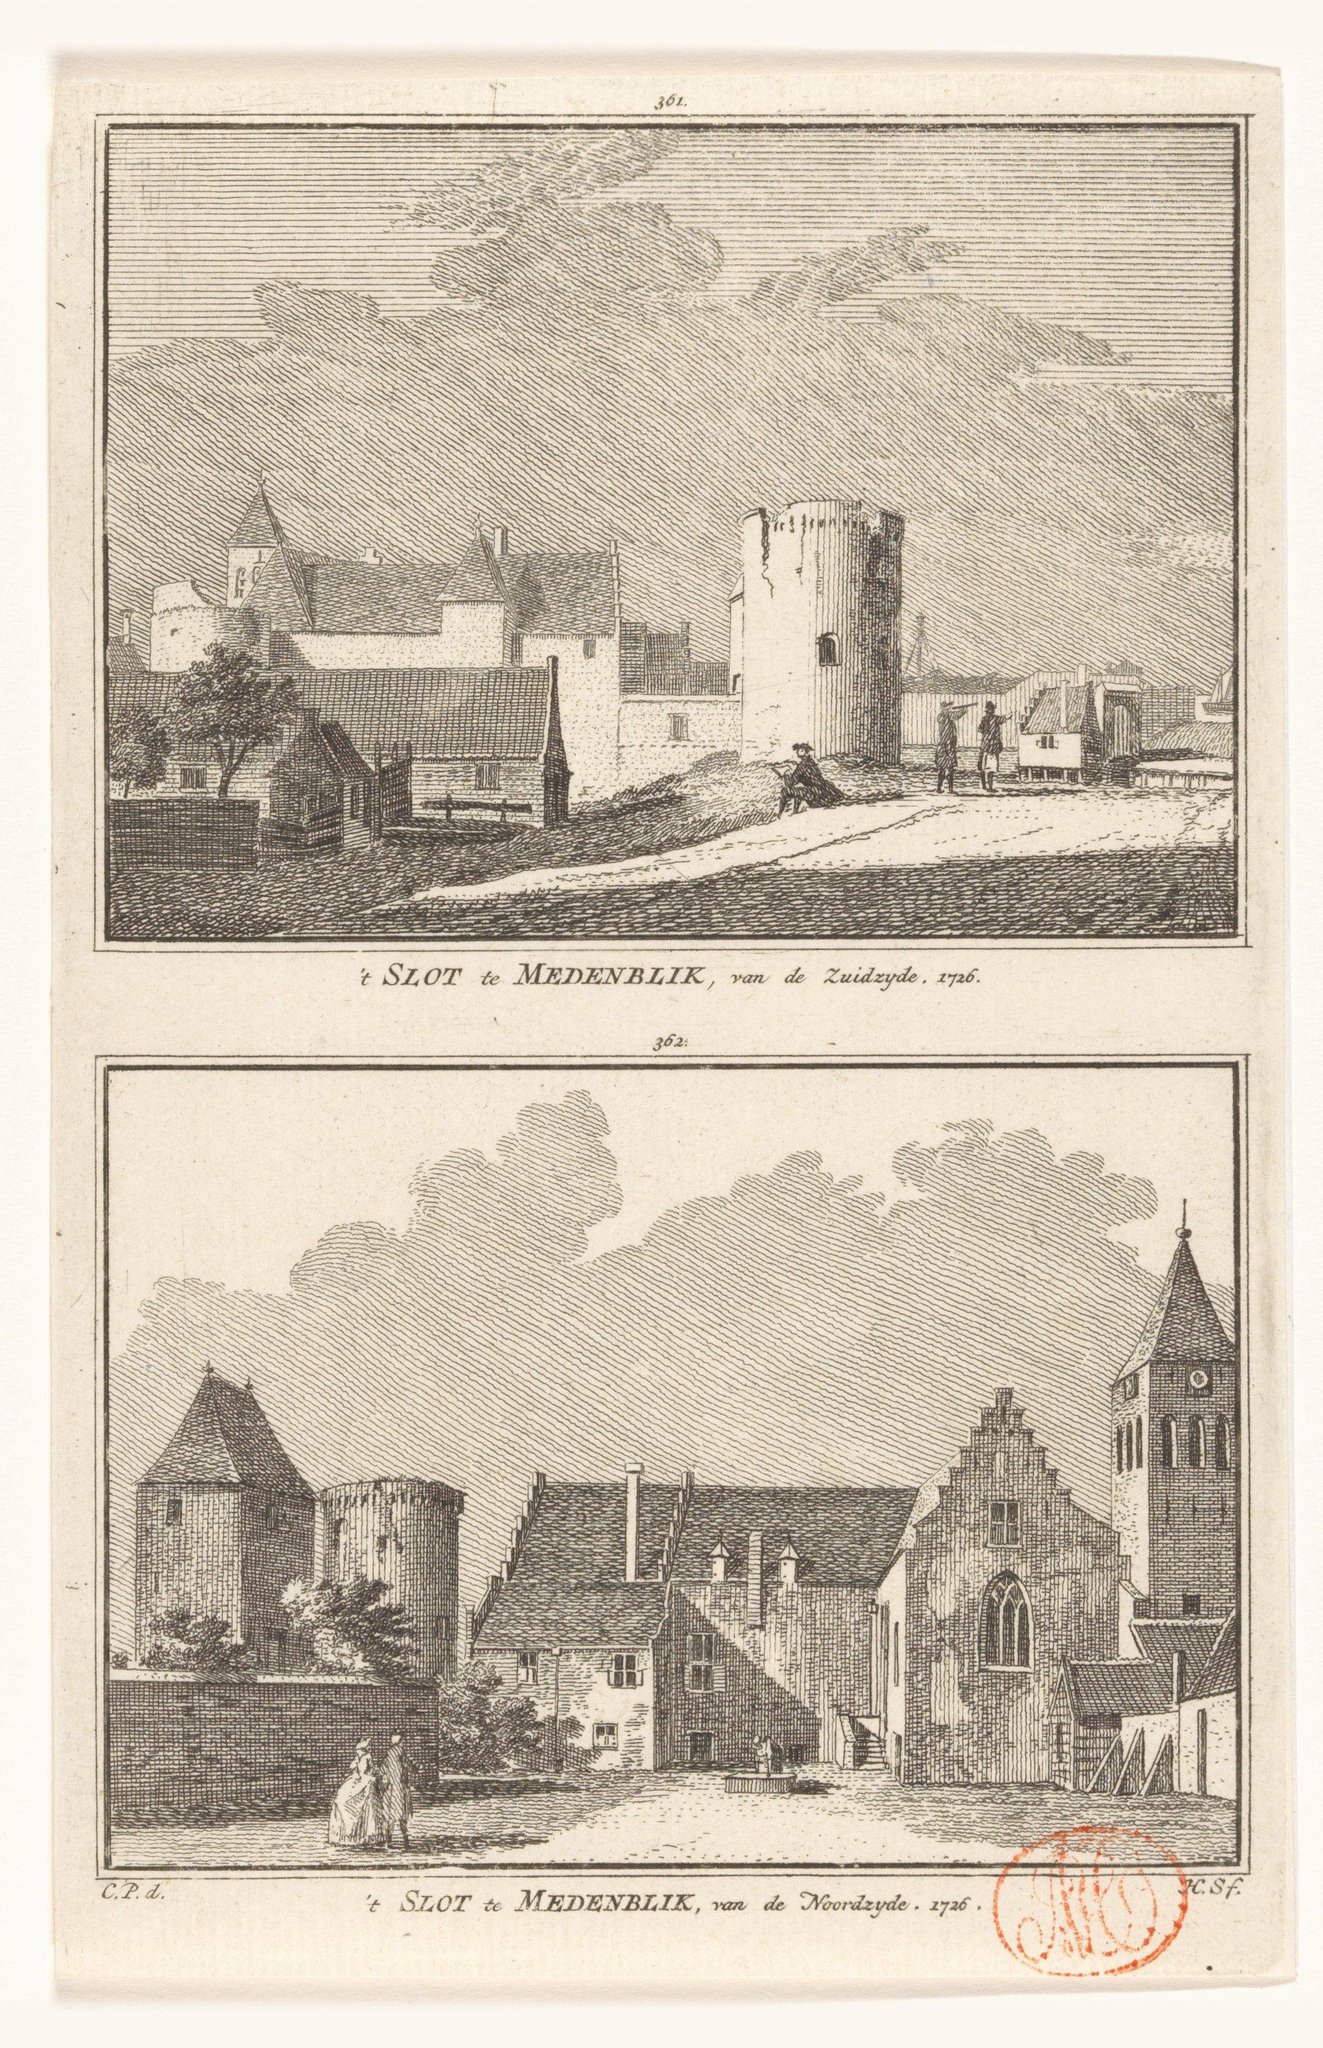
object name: print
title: 't Slot te Medenblik, van de zuidzyde. 1726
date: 1752-1792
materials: paper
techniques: engraving, etching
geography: haarlem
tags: castle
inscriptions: collector's mark: Lugt 195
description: Prent ook gebruikt in: Het verheerlykt Nederland of kabinet van hedendaagsche gezigten van steden, dorpen (…). 9 delen. Amsterdam: Isaak Tirion en weduwe Isaak Tirion, 1745-1774, dl. 4 (1752), ill. 361-362. Of in: Nederlandsche tafereelen; of eene keurige verzameling van negen honderd fraaije gezigten van steden, dorpen, sloten, oudheden (….). 9 delen. Amsterdam: Jan de Groot, 1792, dl. 4, ill. 361-362. Uit welke druk het huidige exemplaar precies komt is niet na te gaan.